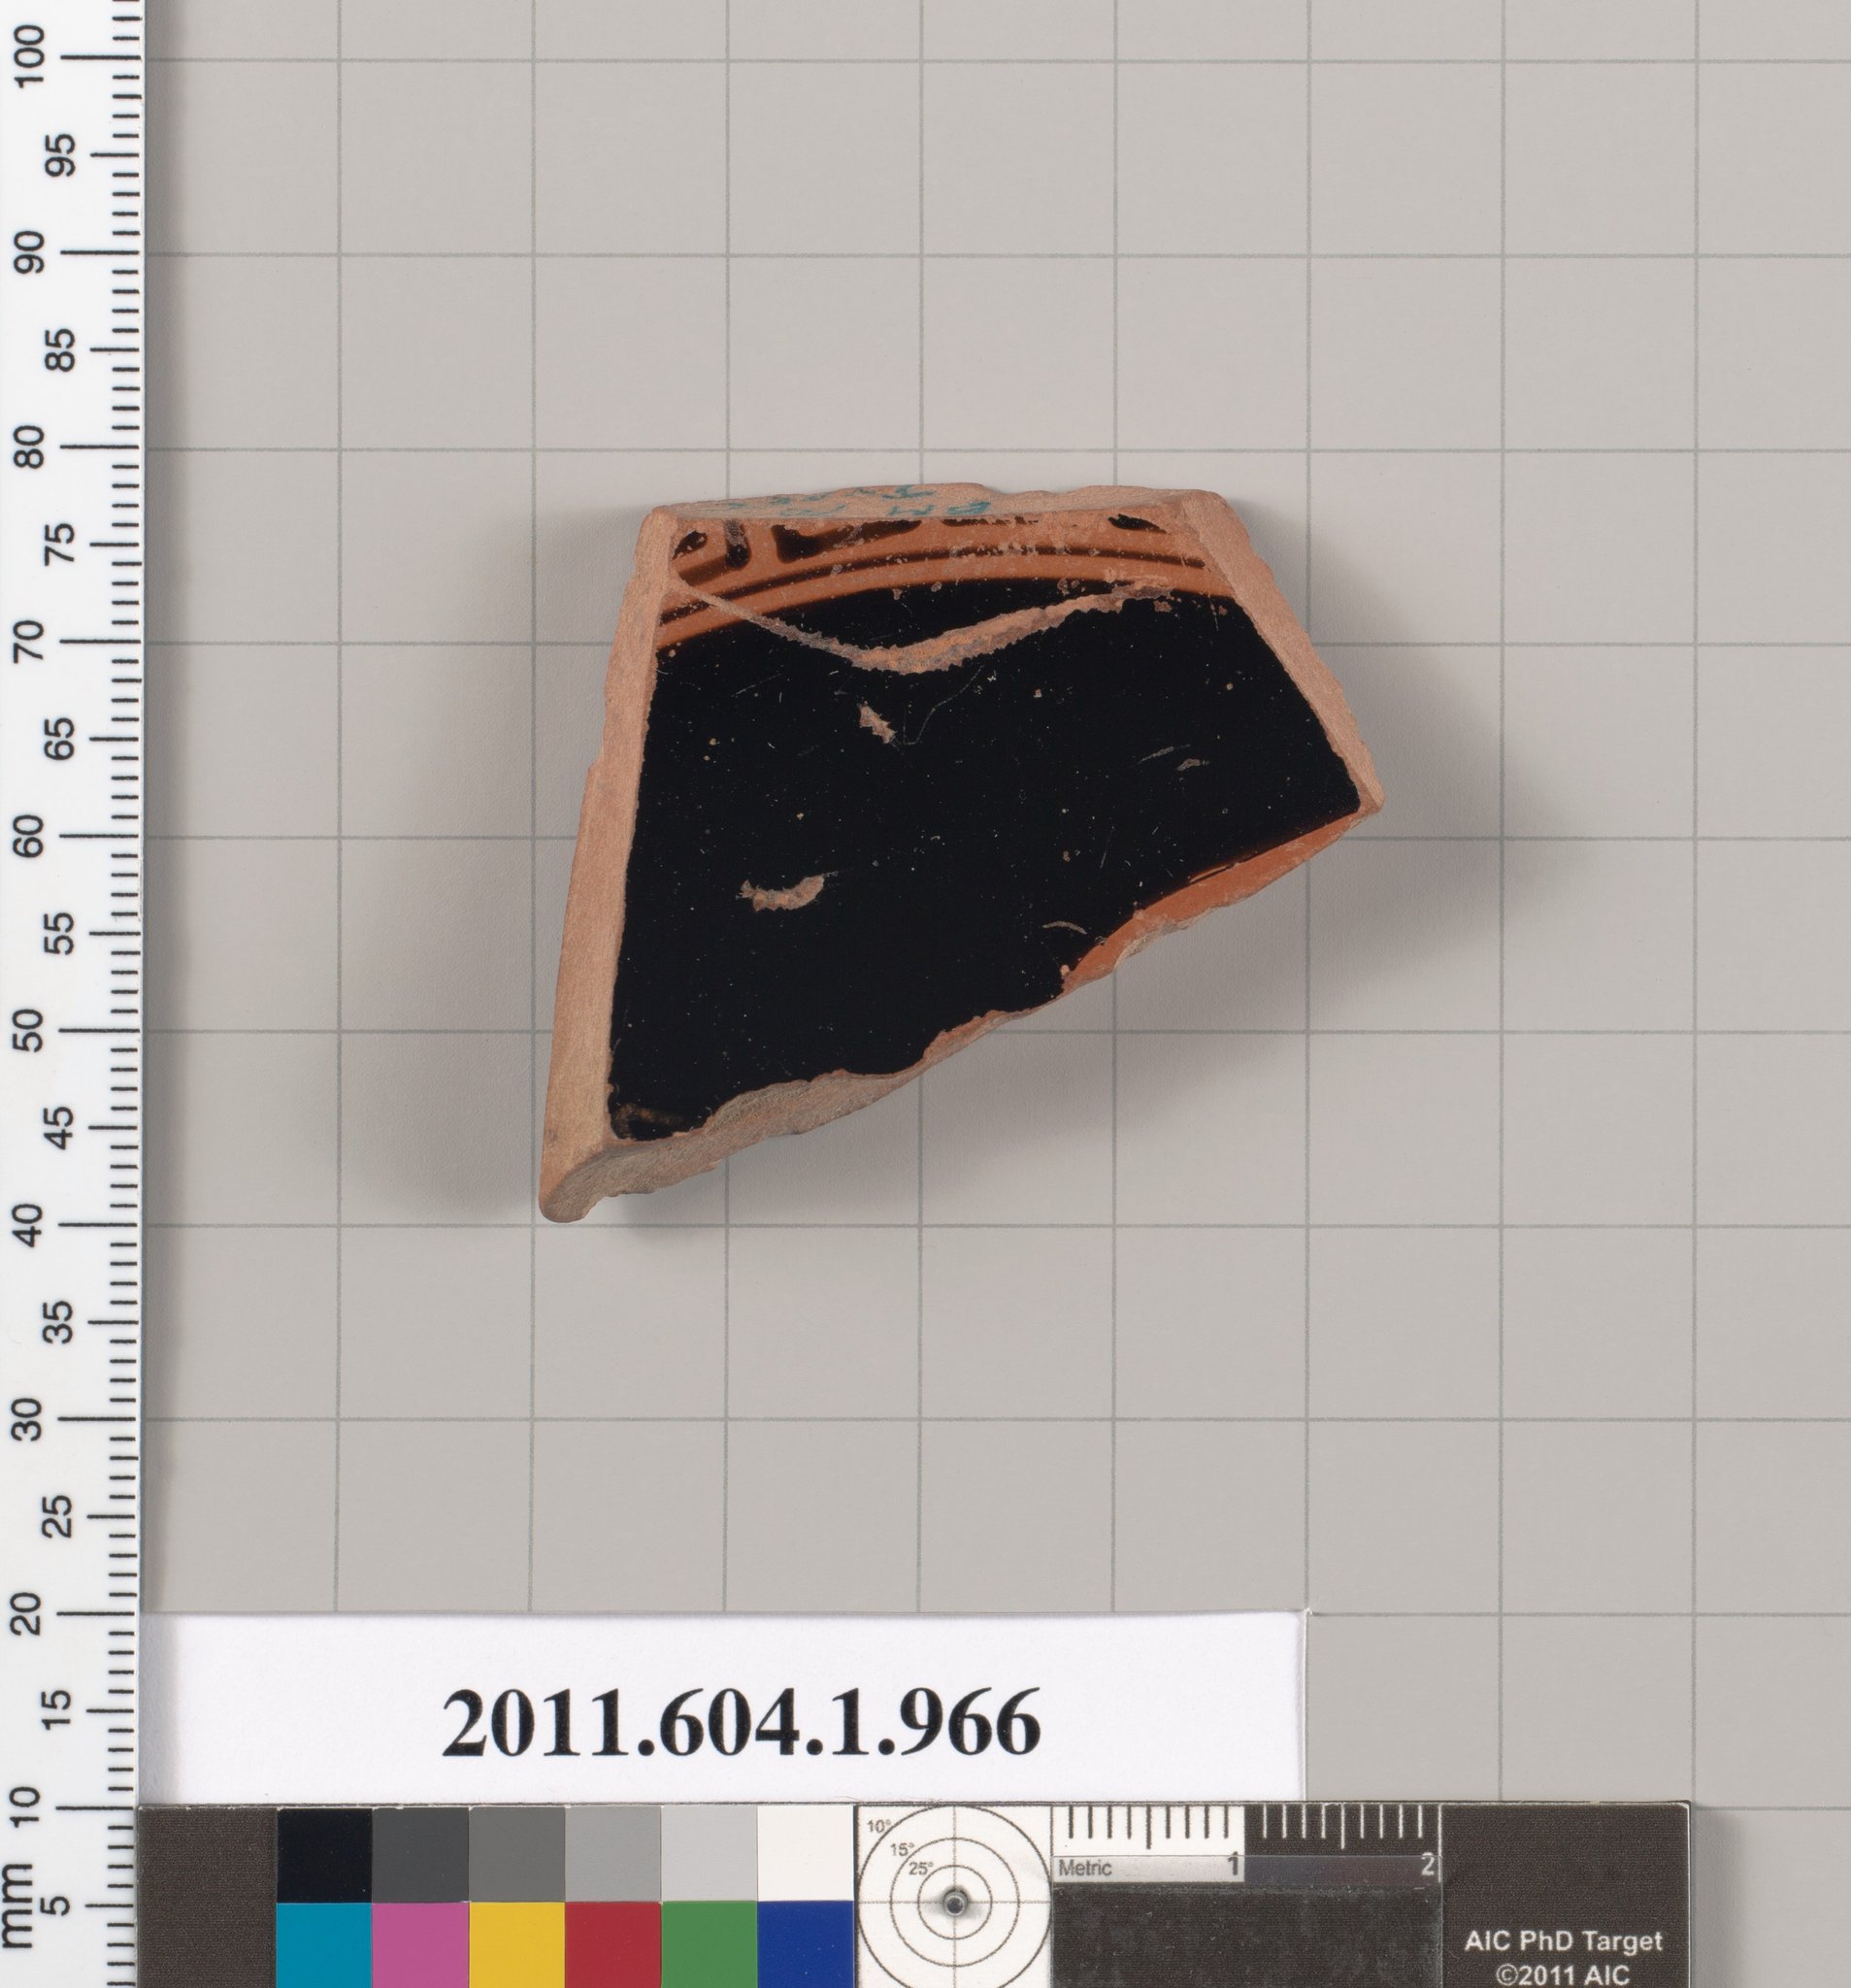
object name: kylix fragment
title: Terracotta fragment of a kylix (drinking cup)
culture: greek, attic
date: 490-480 BCE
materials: terracotta